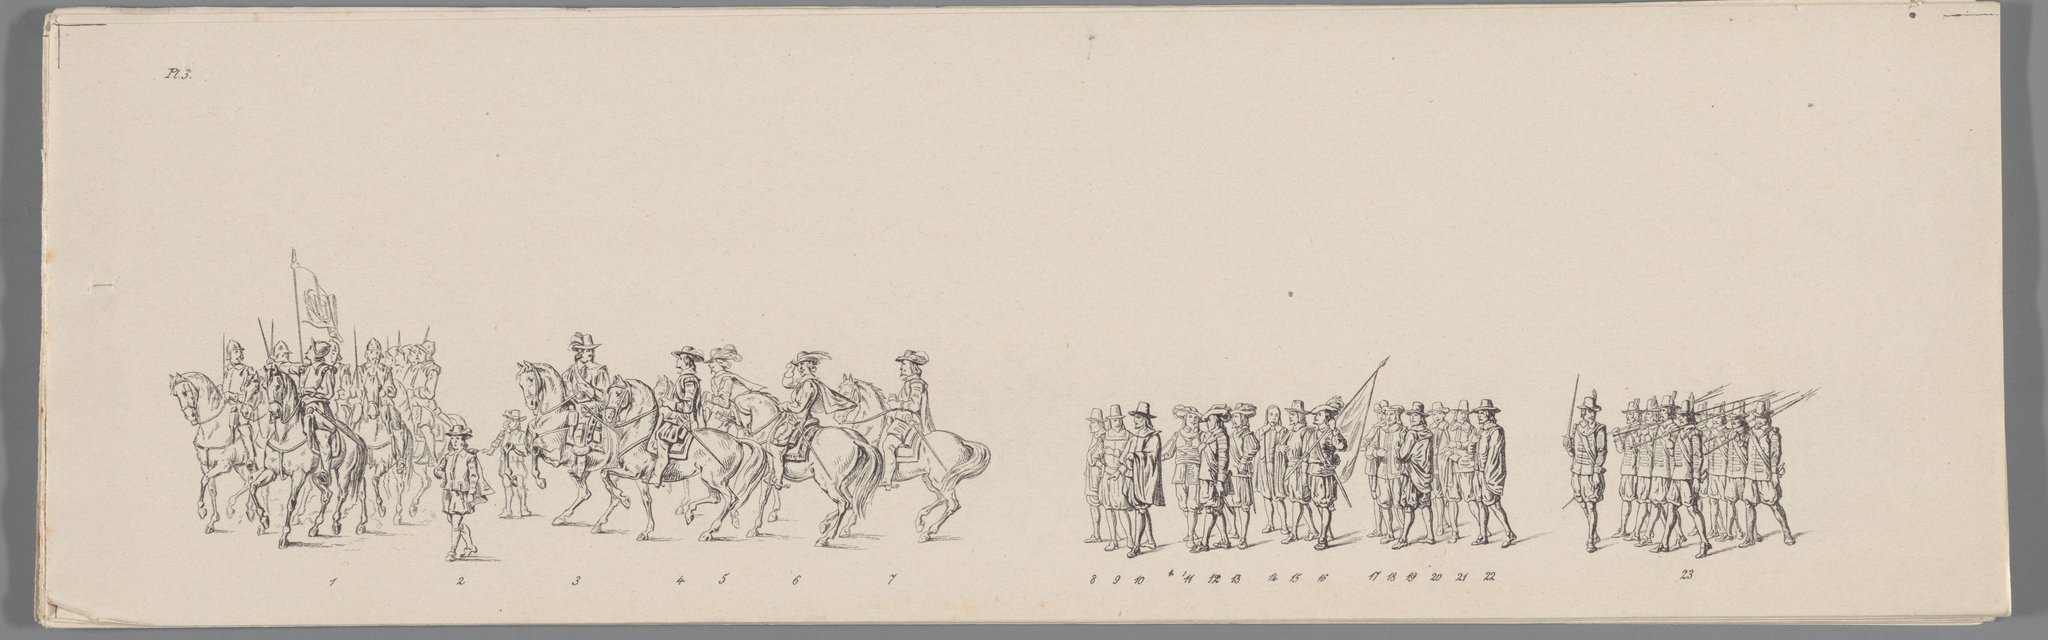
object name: print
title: Historische gekostumeerde optocht te Amsterdam bij het 25-jarige regeringsjubileum van koning Willem III in 1874 (plaat 3)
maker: Anonymous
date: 1874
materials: paper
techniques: lithograph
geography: amsterdam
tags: brussels, willem iii (koning der nederlanden), the hague, frederick henry (prince of orange), public festivities at other royal events, not meant or mentioned above (+ parade, pageant, cavalcade ~ festive activities), costumes used in pageants, amsterdam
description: Plaat nr. 3 met het deel van de optocht met figuren uit de tijd van prins Frederik Hendrik. Onderdeel van een serie van 24 platen van de gekostumeerde historische en allegorische optocht gehouden te Amsterdam op 12 mei 1874, als onderdeel van de feestelijkheden tijdens de viering van het 25-jarige regeringsjubileum van koning Willem III.